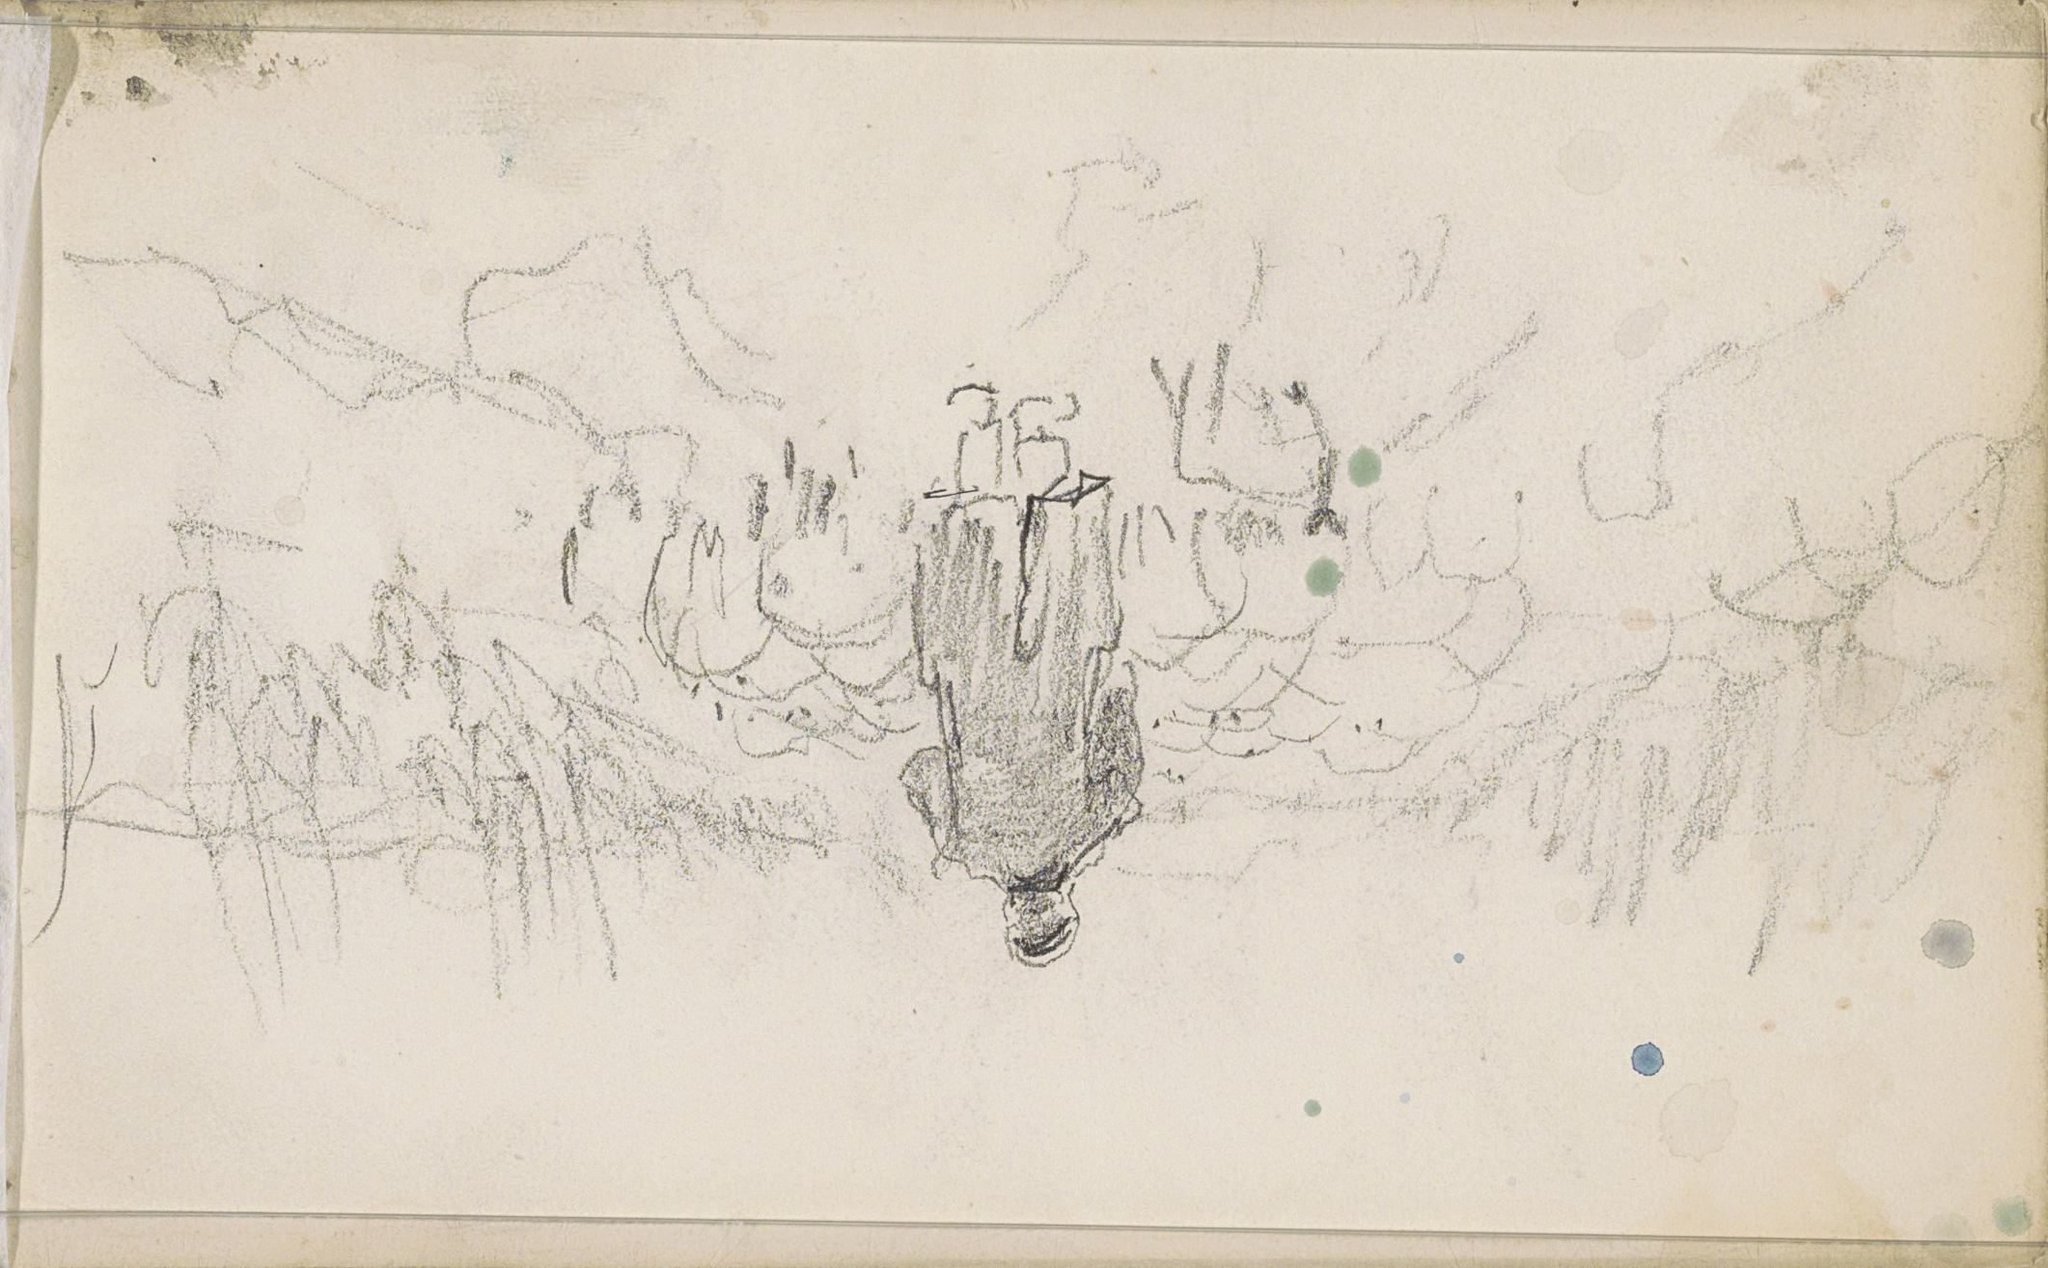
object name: sketchbook leaf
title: Herder met een schaapskudde op een pad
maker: anton mauve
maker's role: draughtsman, painter, print maker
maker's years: 1838-1888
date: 1848-1888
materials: paper, pencil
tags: herding, herdsman, herdswoman, shepherd, shepherdess, cowherd, etc., road, path, sheep, herd, flock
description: Blad 7 recto uit een schetsboek met 44 bladen.